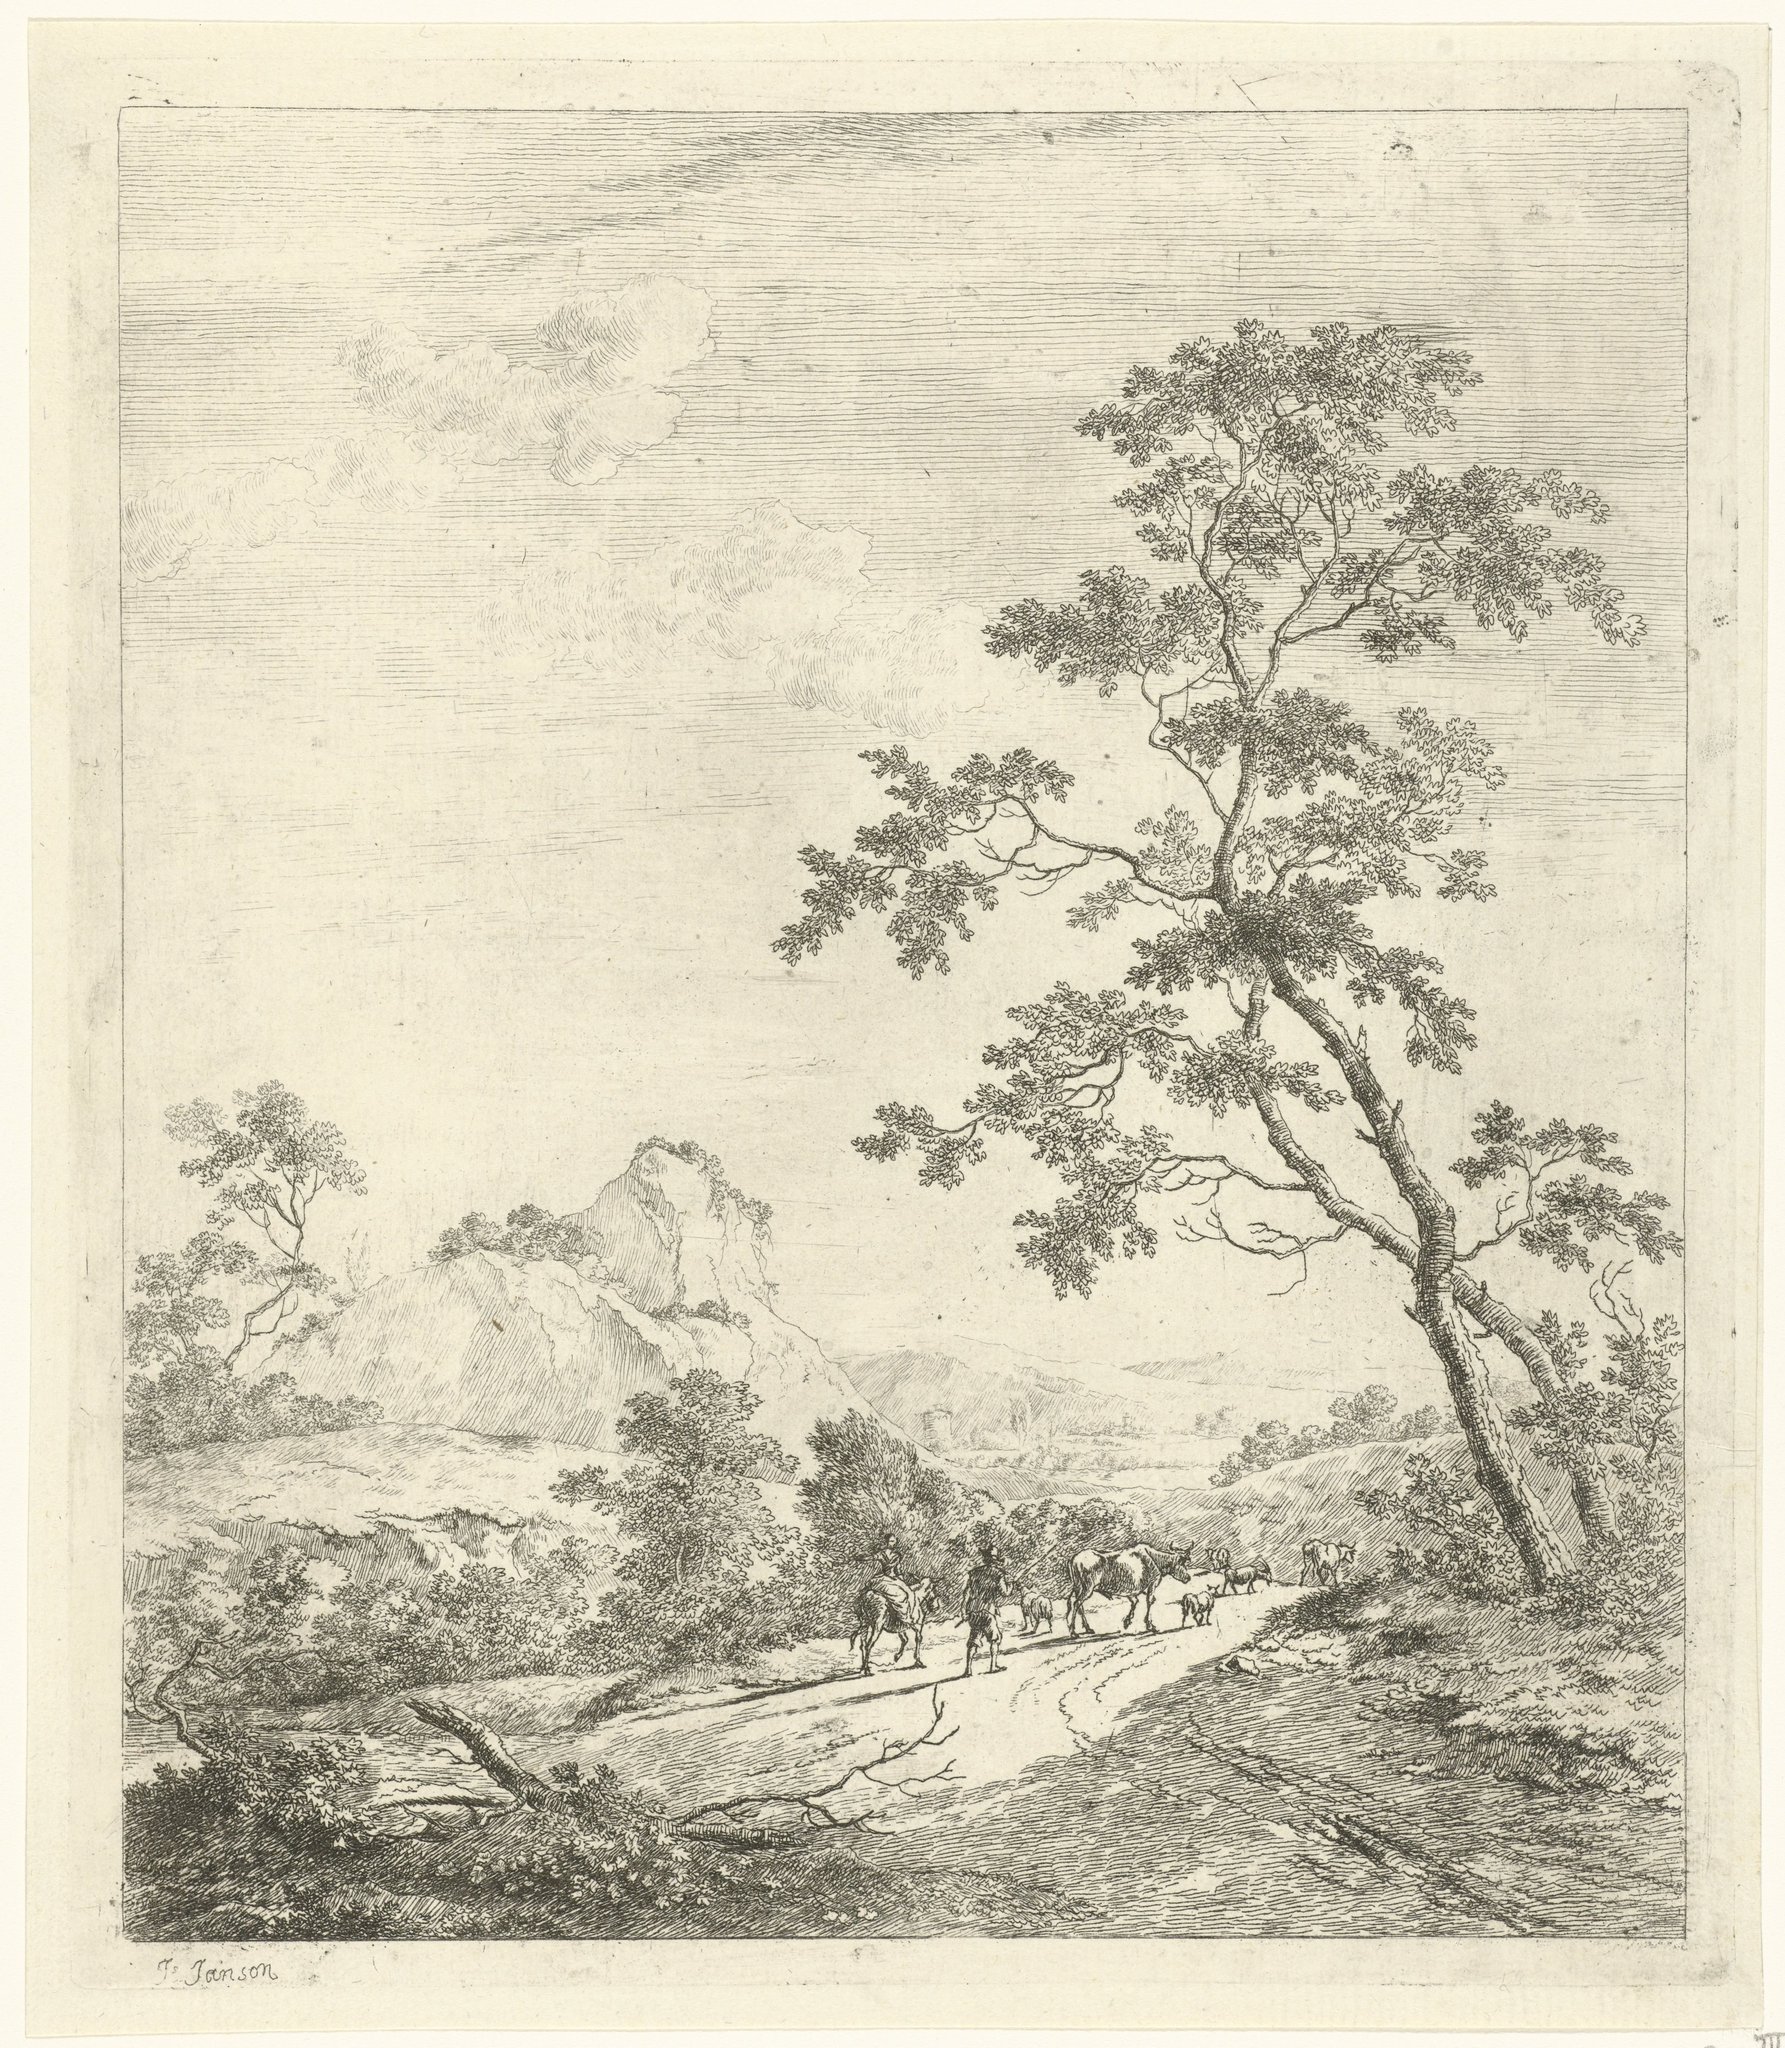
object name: print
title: Bergachtig landschap met herder en herderin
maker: johannes janson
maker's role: draughtsman, painter, print maker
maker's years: 1729-1784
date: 1761-1784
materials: paper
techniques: etching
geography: leiden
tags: ass, donkey, pastorals, arcadian scenes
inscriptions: collector's mark: Lugt 2228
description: Bergachtig landschap met pad waarop een herder die zijn vee voortdrijft. Naast hem een herderin, zittend op een ezel. Rechts langs het pad een boom.